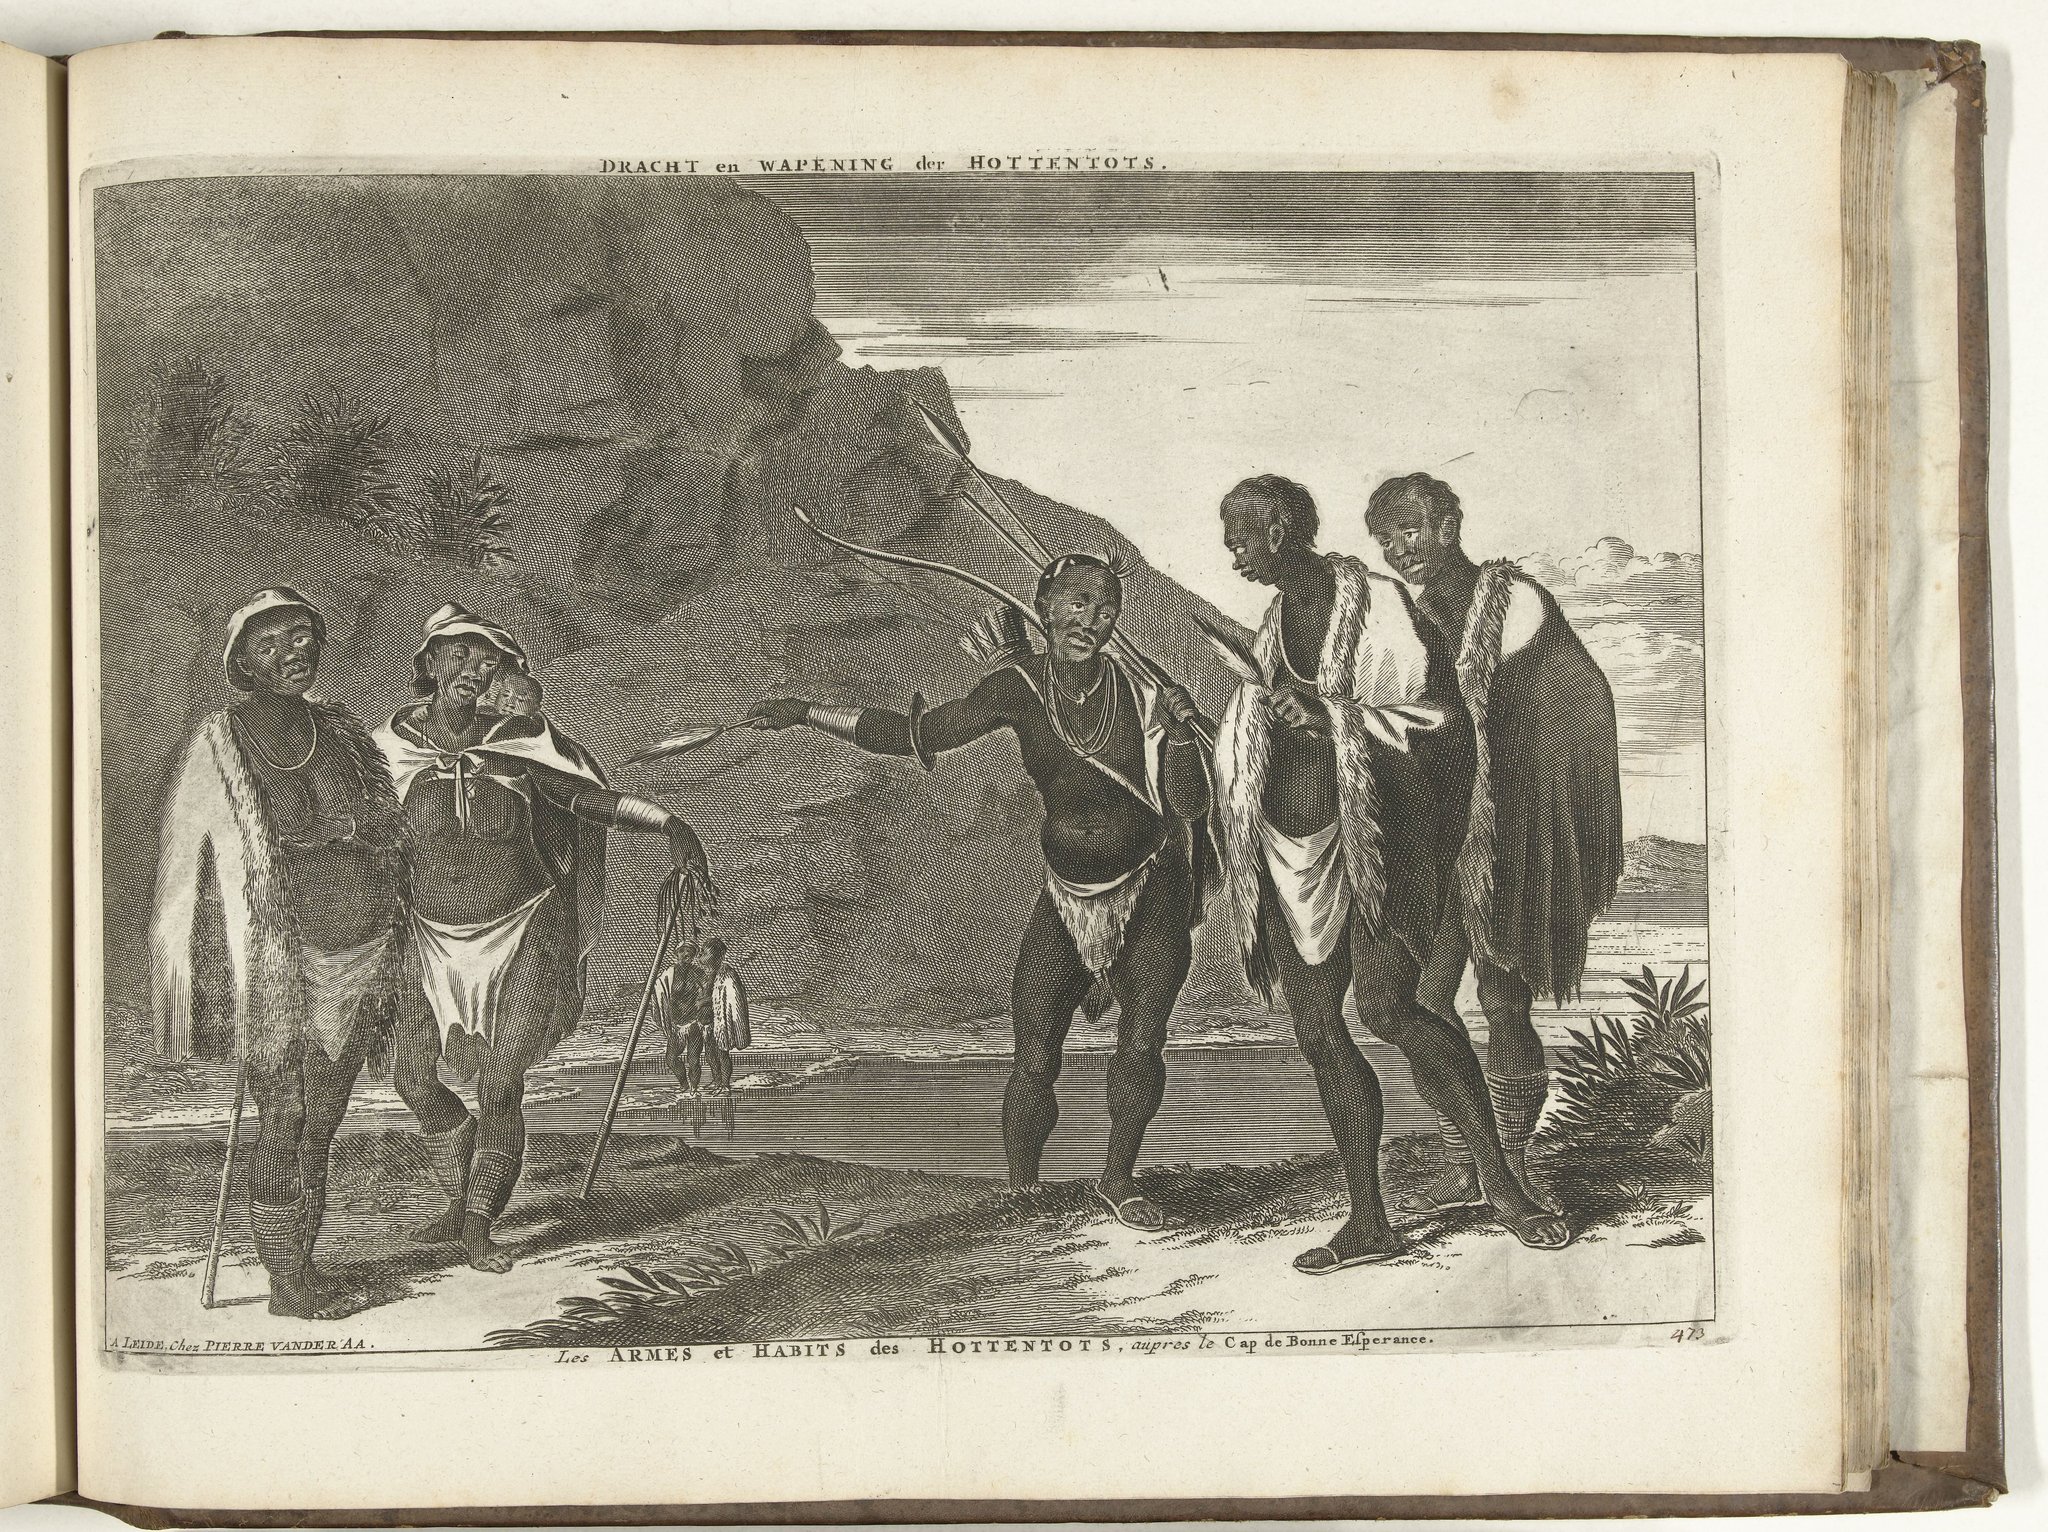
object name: print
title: Les Forces de l'Europe, Asie, Afrique et Amerique (...) Comme aussi les Cartes des Côtes de France et d'Espagne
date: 1726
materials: paper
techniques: engraving, etching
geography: leiden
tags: khoikhoi, cape of good hope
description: Khoikhoi, inwoners van Kaap de Goede Hoop. Links twee vrouwen, rechts drie mannen. Plaat nr. 473 in deel XIX van het prentwerk: Les Forces de l'Europe, Asie, Afrique et Amerique ... Comme aussi les Cartes des Côtes de France et d'Espagne uit 1726, dit tweede deel met 271 met de hand genummerde platen van vermaarde sterke steden en vestingen in het kader van de Spaanse Successieoorlog 1701-1713. Voor het merendeel zijn deze platen gekopieerd naar de anonieme Franse platen van vermaarde sterke steden en vestingen: in Les forces de l'Europe en in: Le theatre de la guerre, dans les Pays-Bas, beide oorspronkelijk uitgegeven door Nicolas de Fer te Parijs (1693-1697) in het kader van de Negenjarige Oorlog. Titels in het Nederlands en Frans.